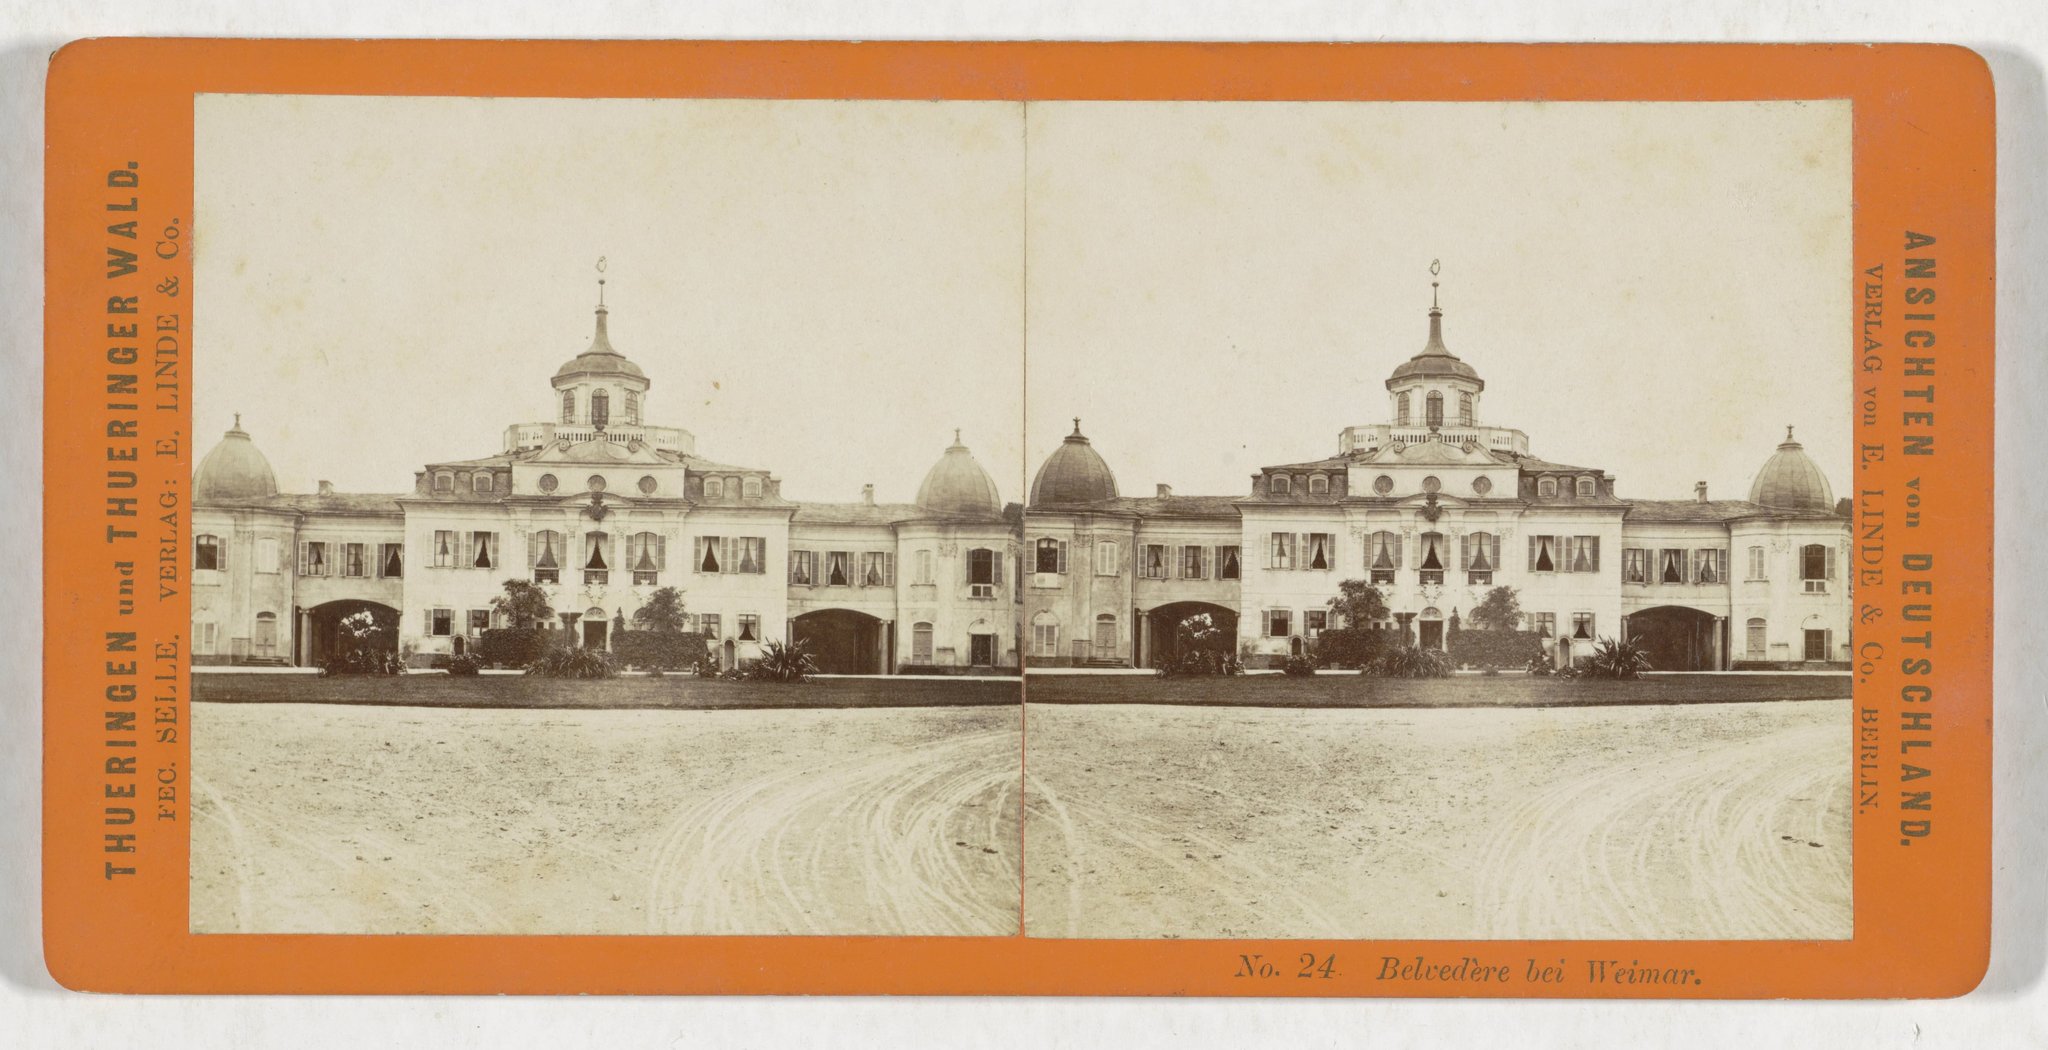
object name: stereograph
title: Ansichten von Deutschland / Thüringen und Thüringer Wald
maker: hermann selle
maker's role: fotograaf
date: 1868-1890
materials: cardboard, paper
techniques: albumen print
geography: weimar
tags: palace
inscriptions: number: ‘No. 24.’